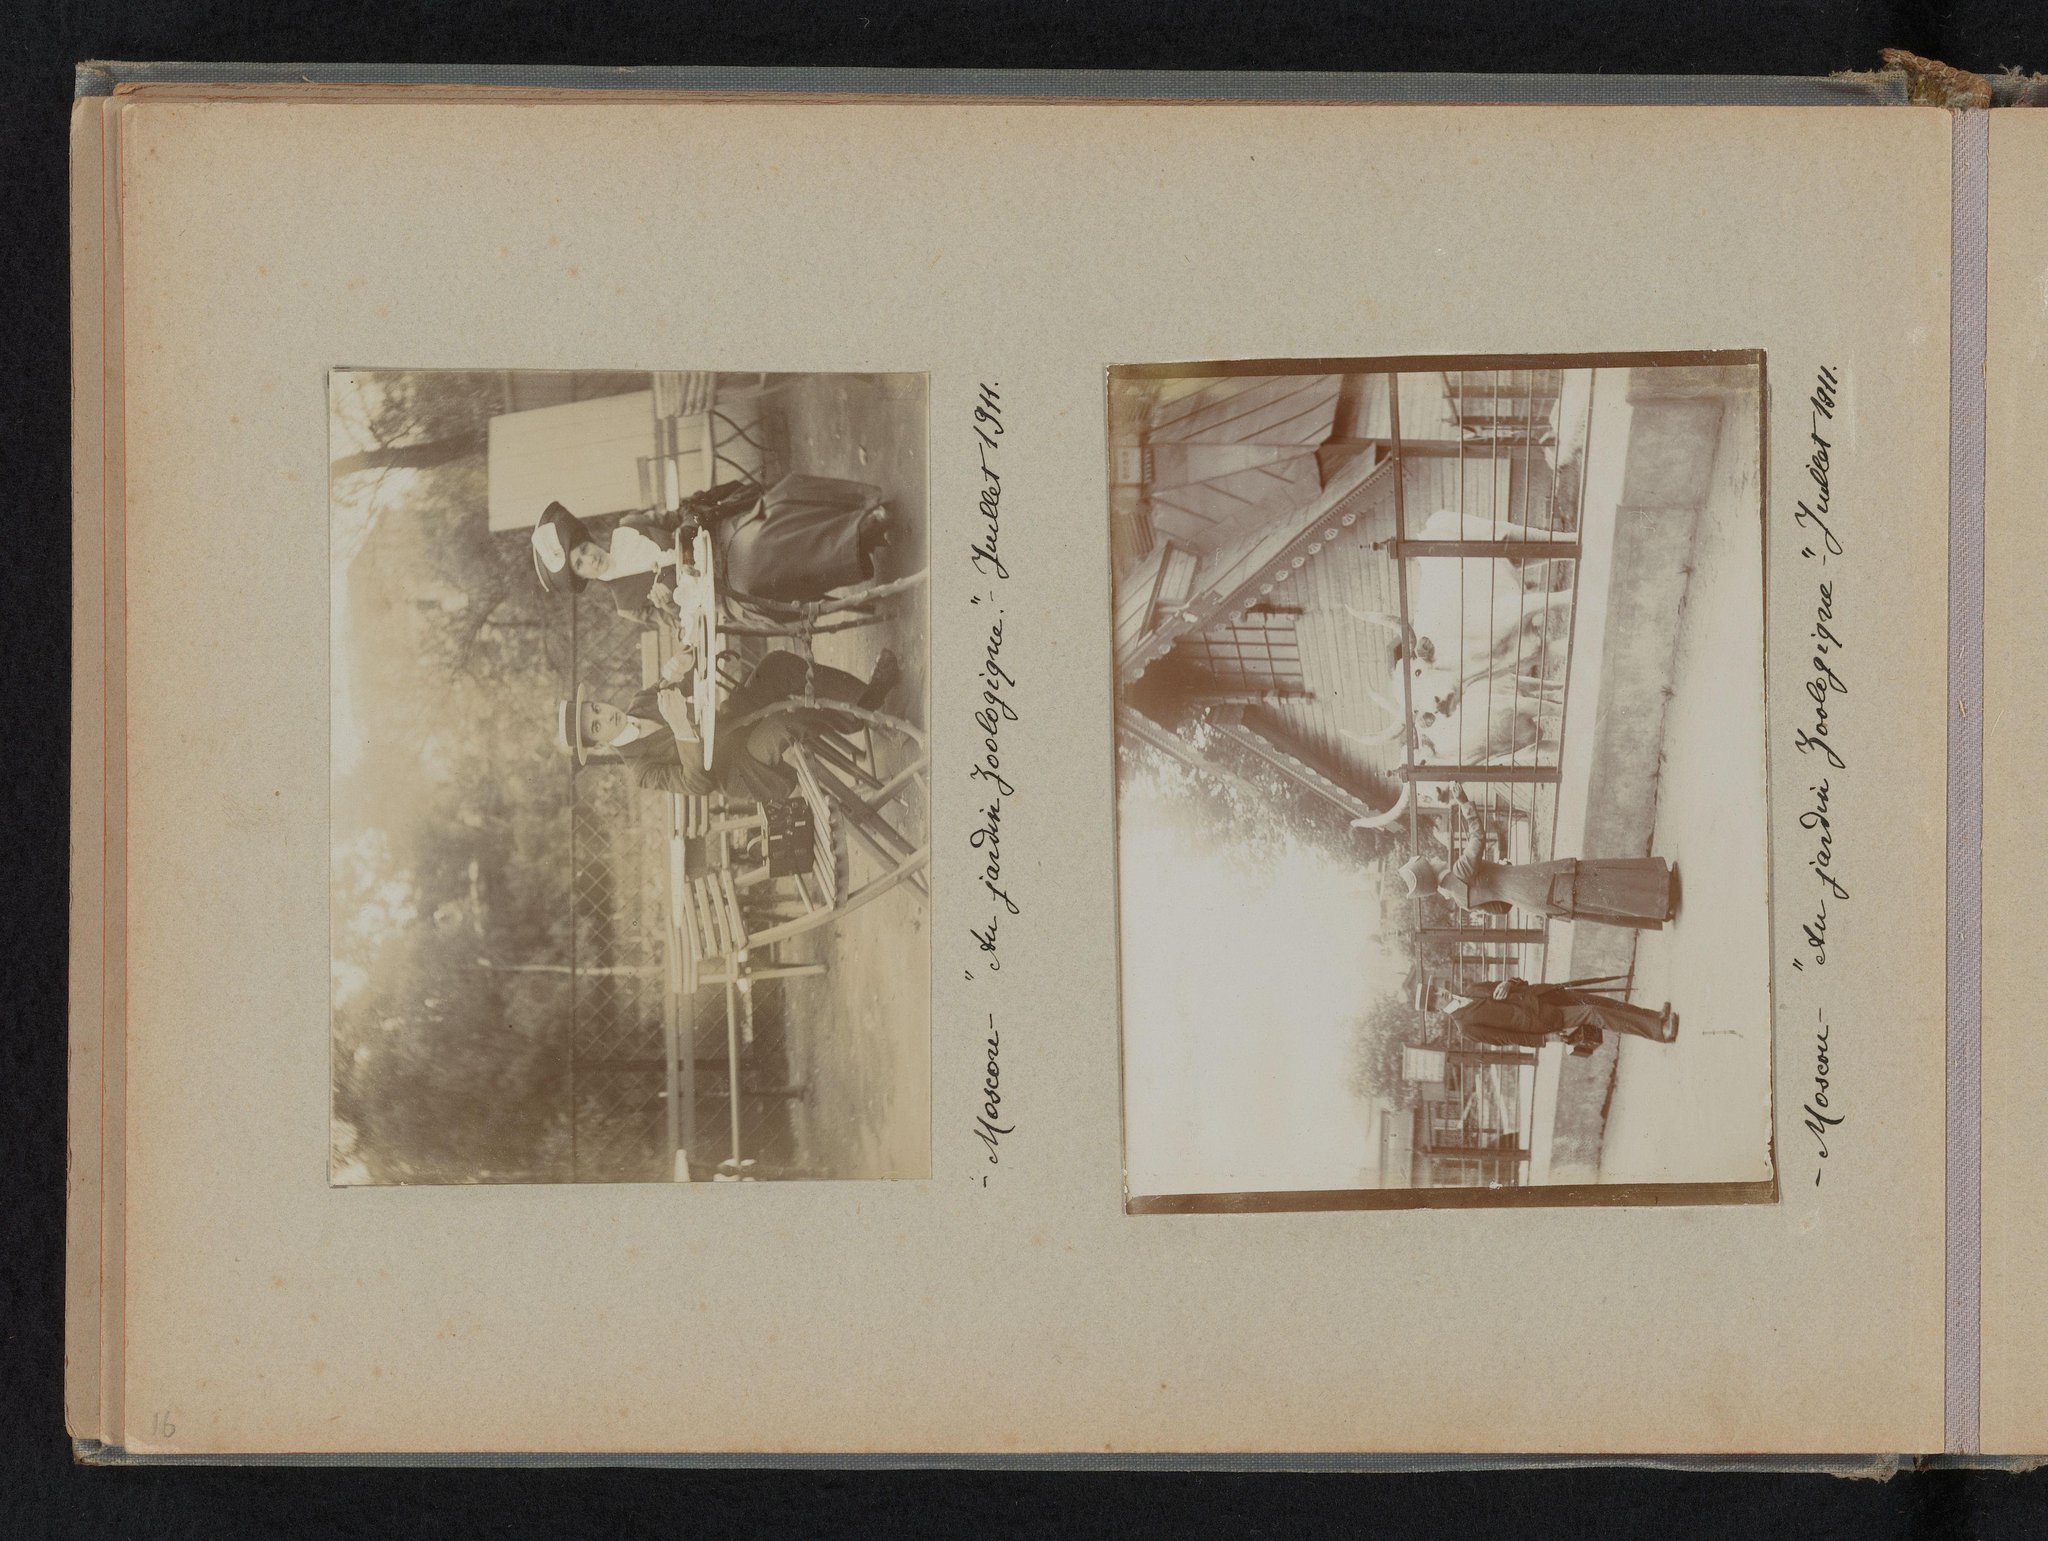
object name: photograph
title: Man en vrouw bij de dierentuin van Moskou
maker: Anonymous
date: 1907-1911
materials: paper, cardboard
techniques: collodion silver print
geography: moscow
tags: historical persons, terrace, zoo (as place of recreation)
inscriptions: inscription: ‘- Moscou - "du jardin zoologique -" Juillet 1911.’, inscription: ‘- Moscou - "du jardin zoologique." - Juillet 1911.’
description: Deze foto's maken deel uit van een album.